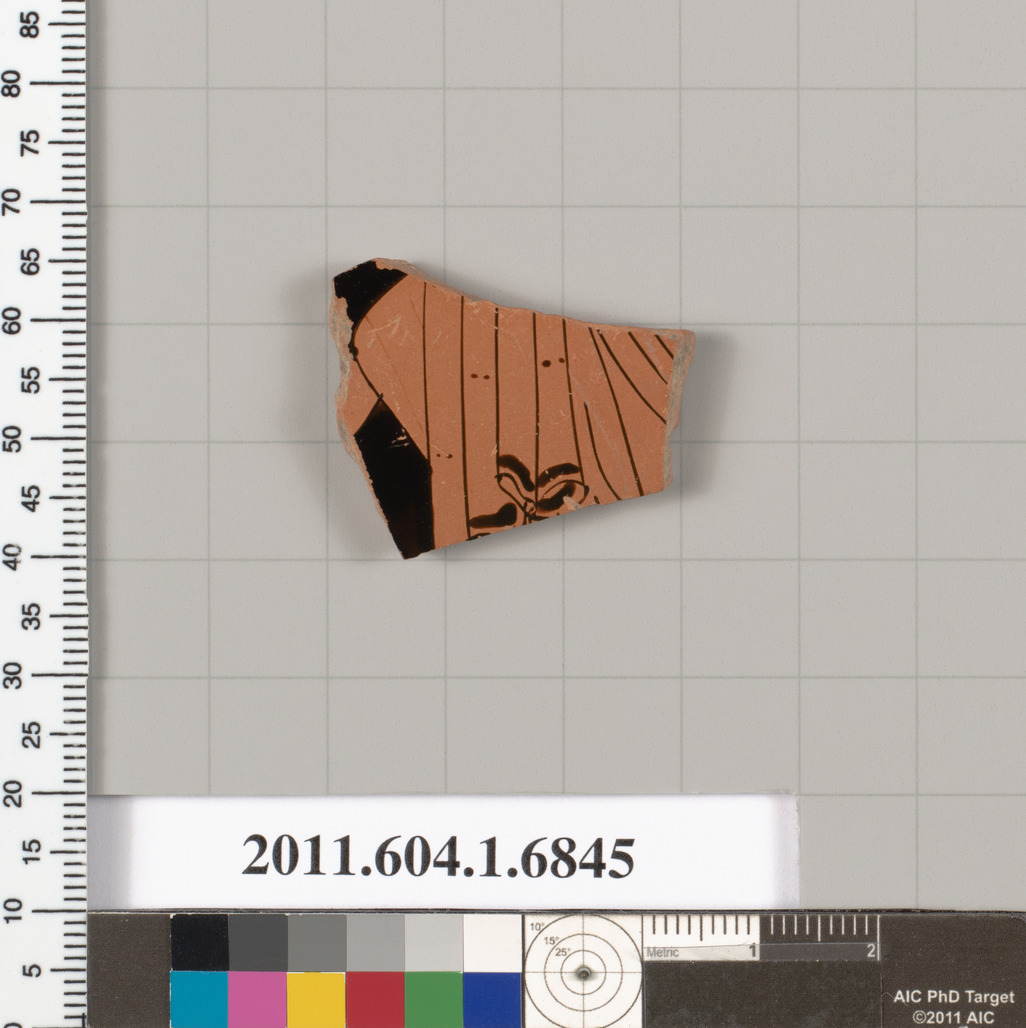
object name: kylix fragment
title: Terracotta fragment of a kylix (drinking cup)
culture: greek, attic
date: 490-470 BCE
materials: terracotta